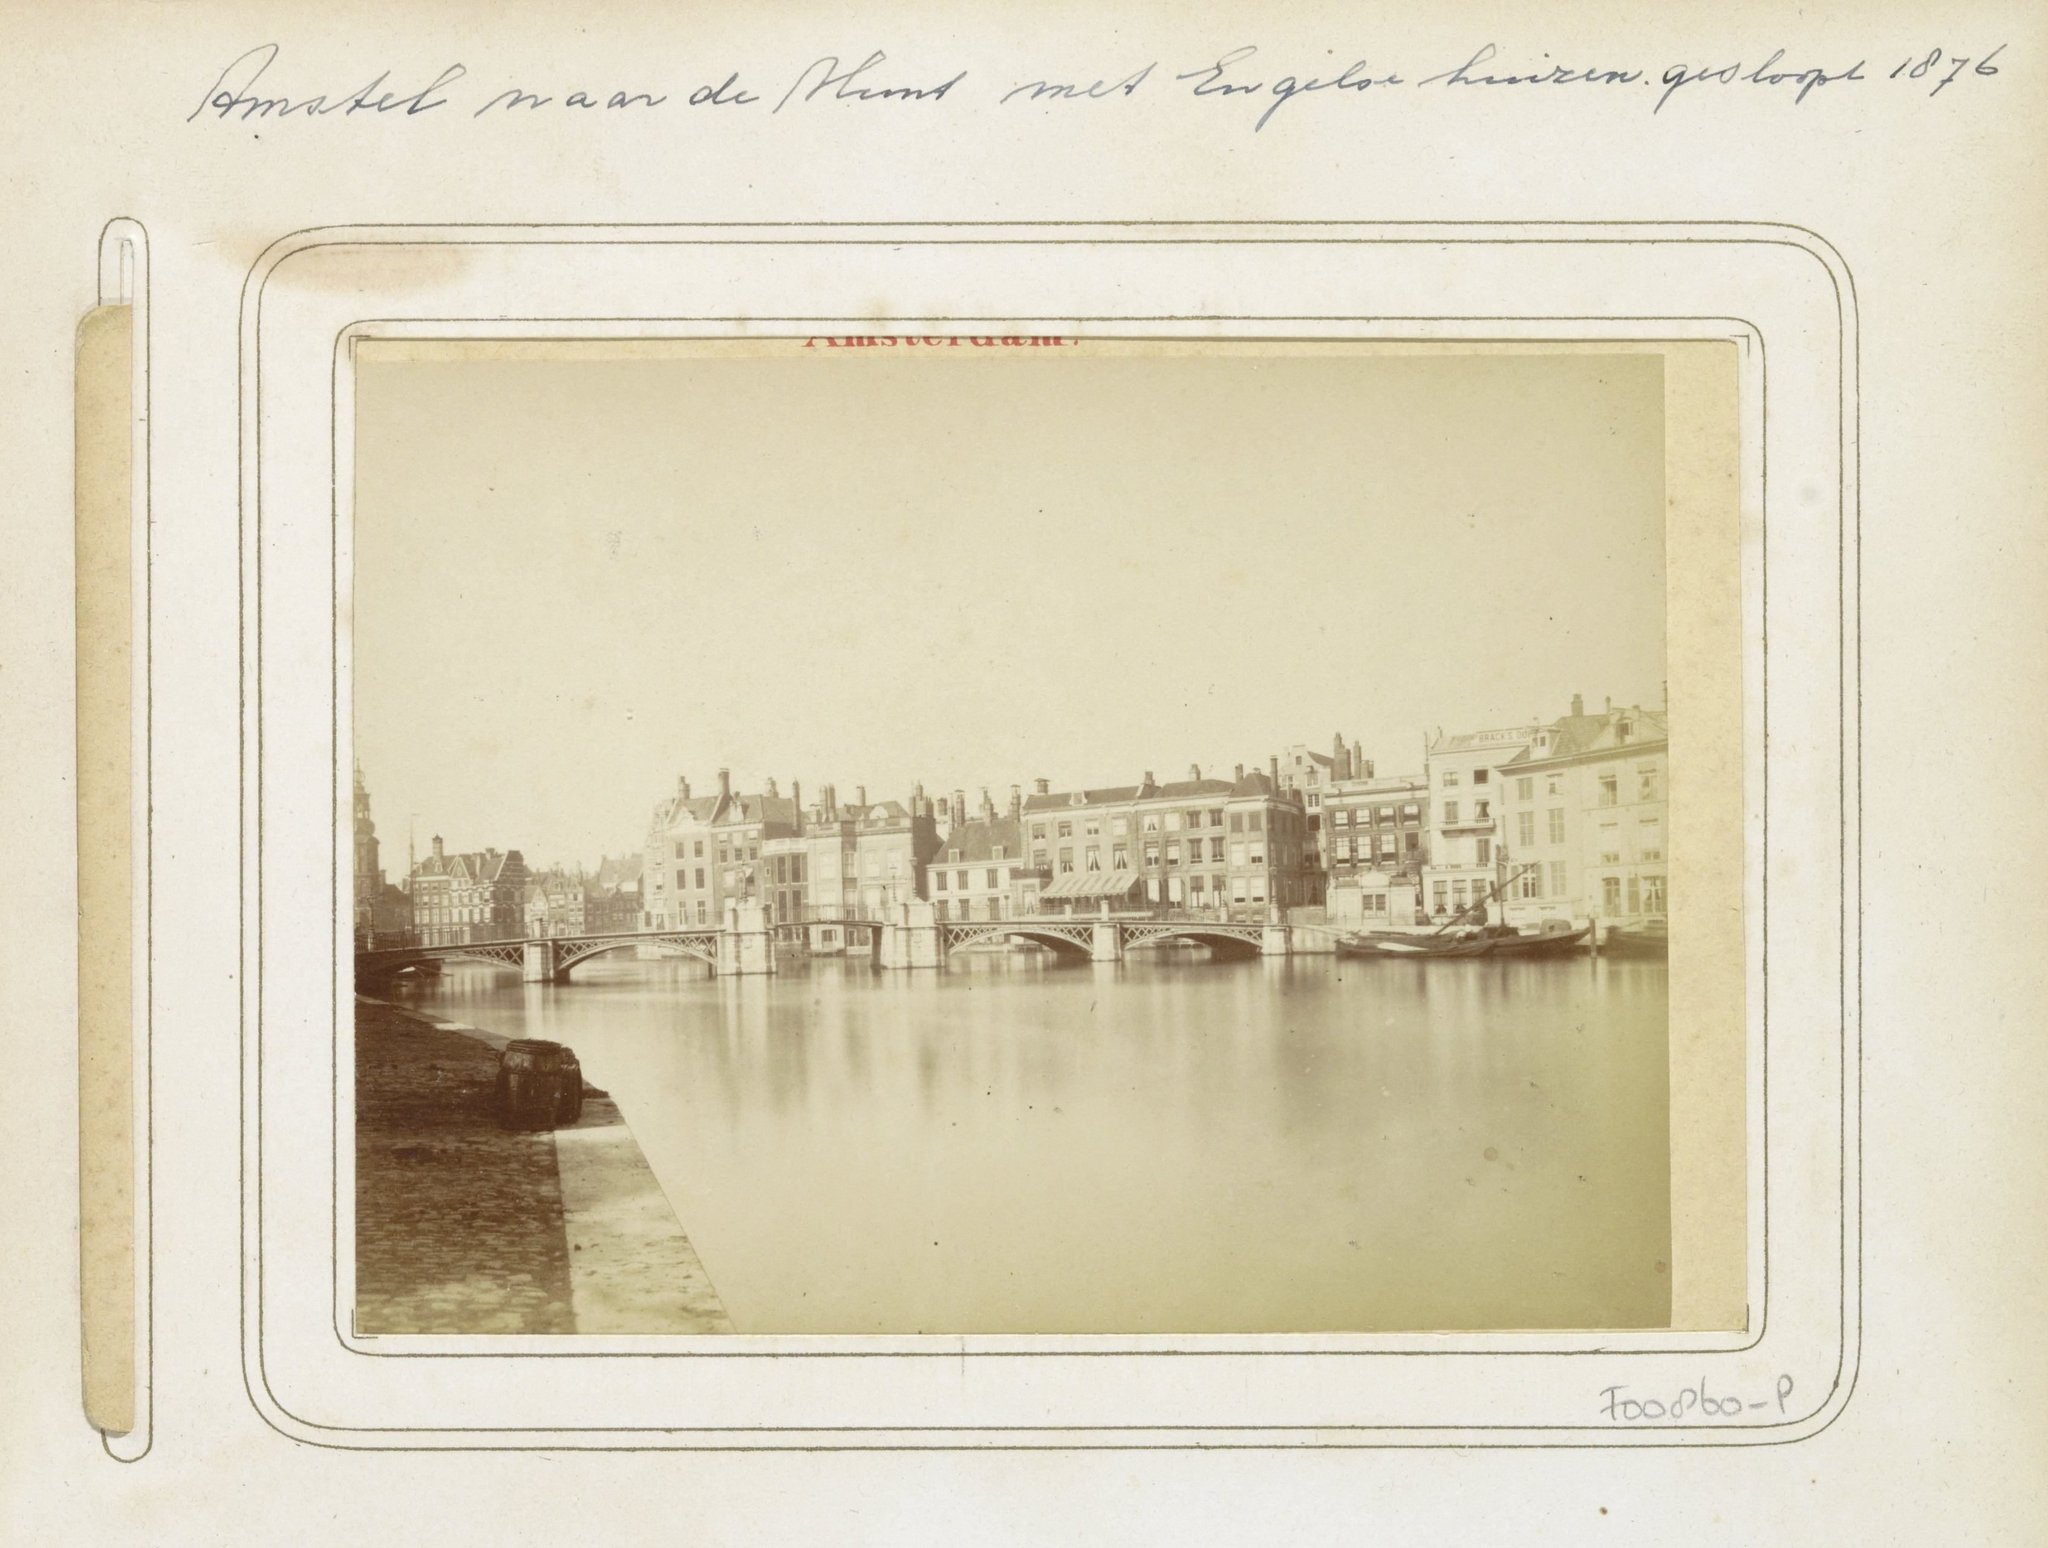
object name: photograph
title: Amstel gezien richting de Munttoren met meteen rechts daarvan de Engelse huizen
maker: pieter oosterhuis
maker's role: draughtsman, print maker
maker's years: 1816-1885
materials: cardboard, paper, photographic support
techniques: albumen print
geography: amsterdam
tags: canals, waters (in city), façade (of house or building), prospect of city, town panorama, silhouette of city, amsterdam